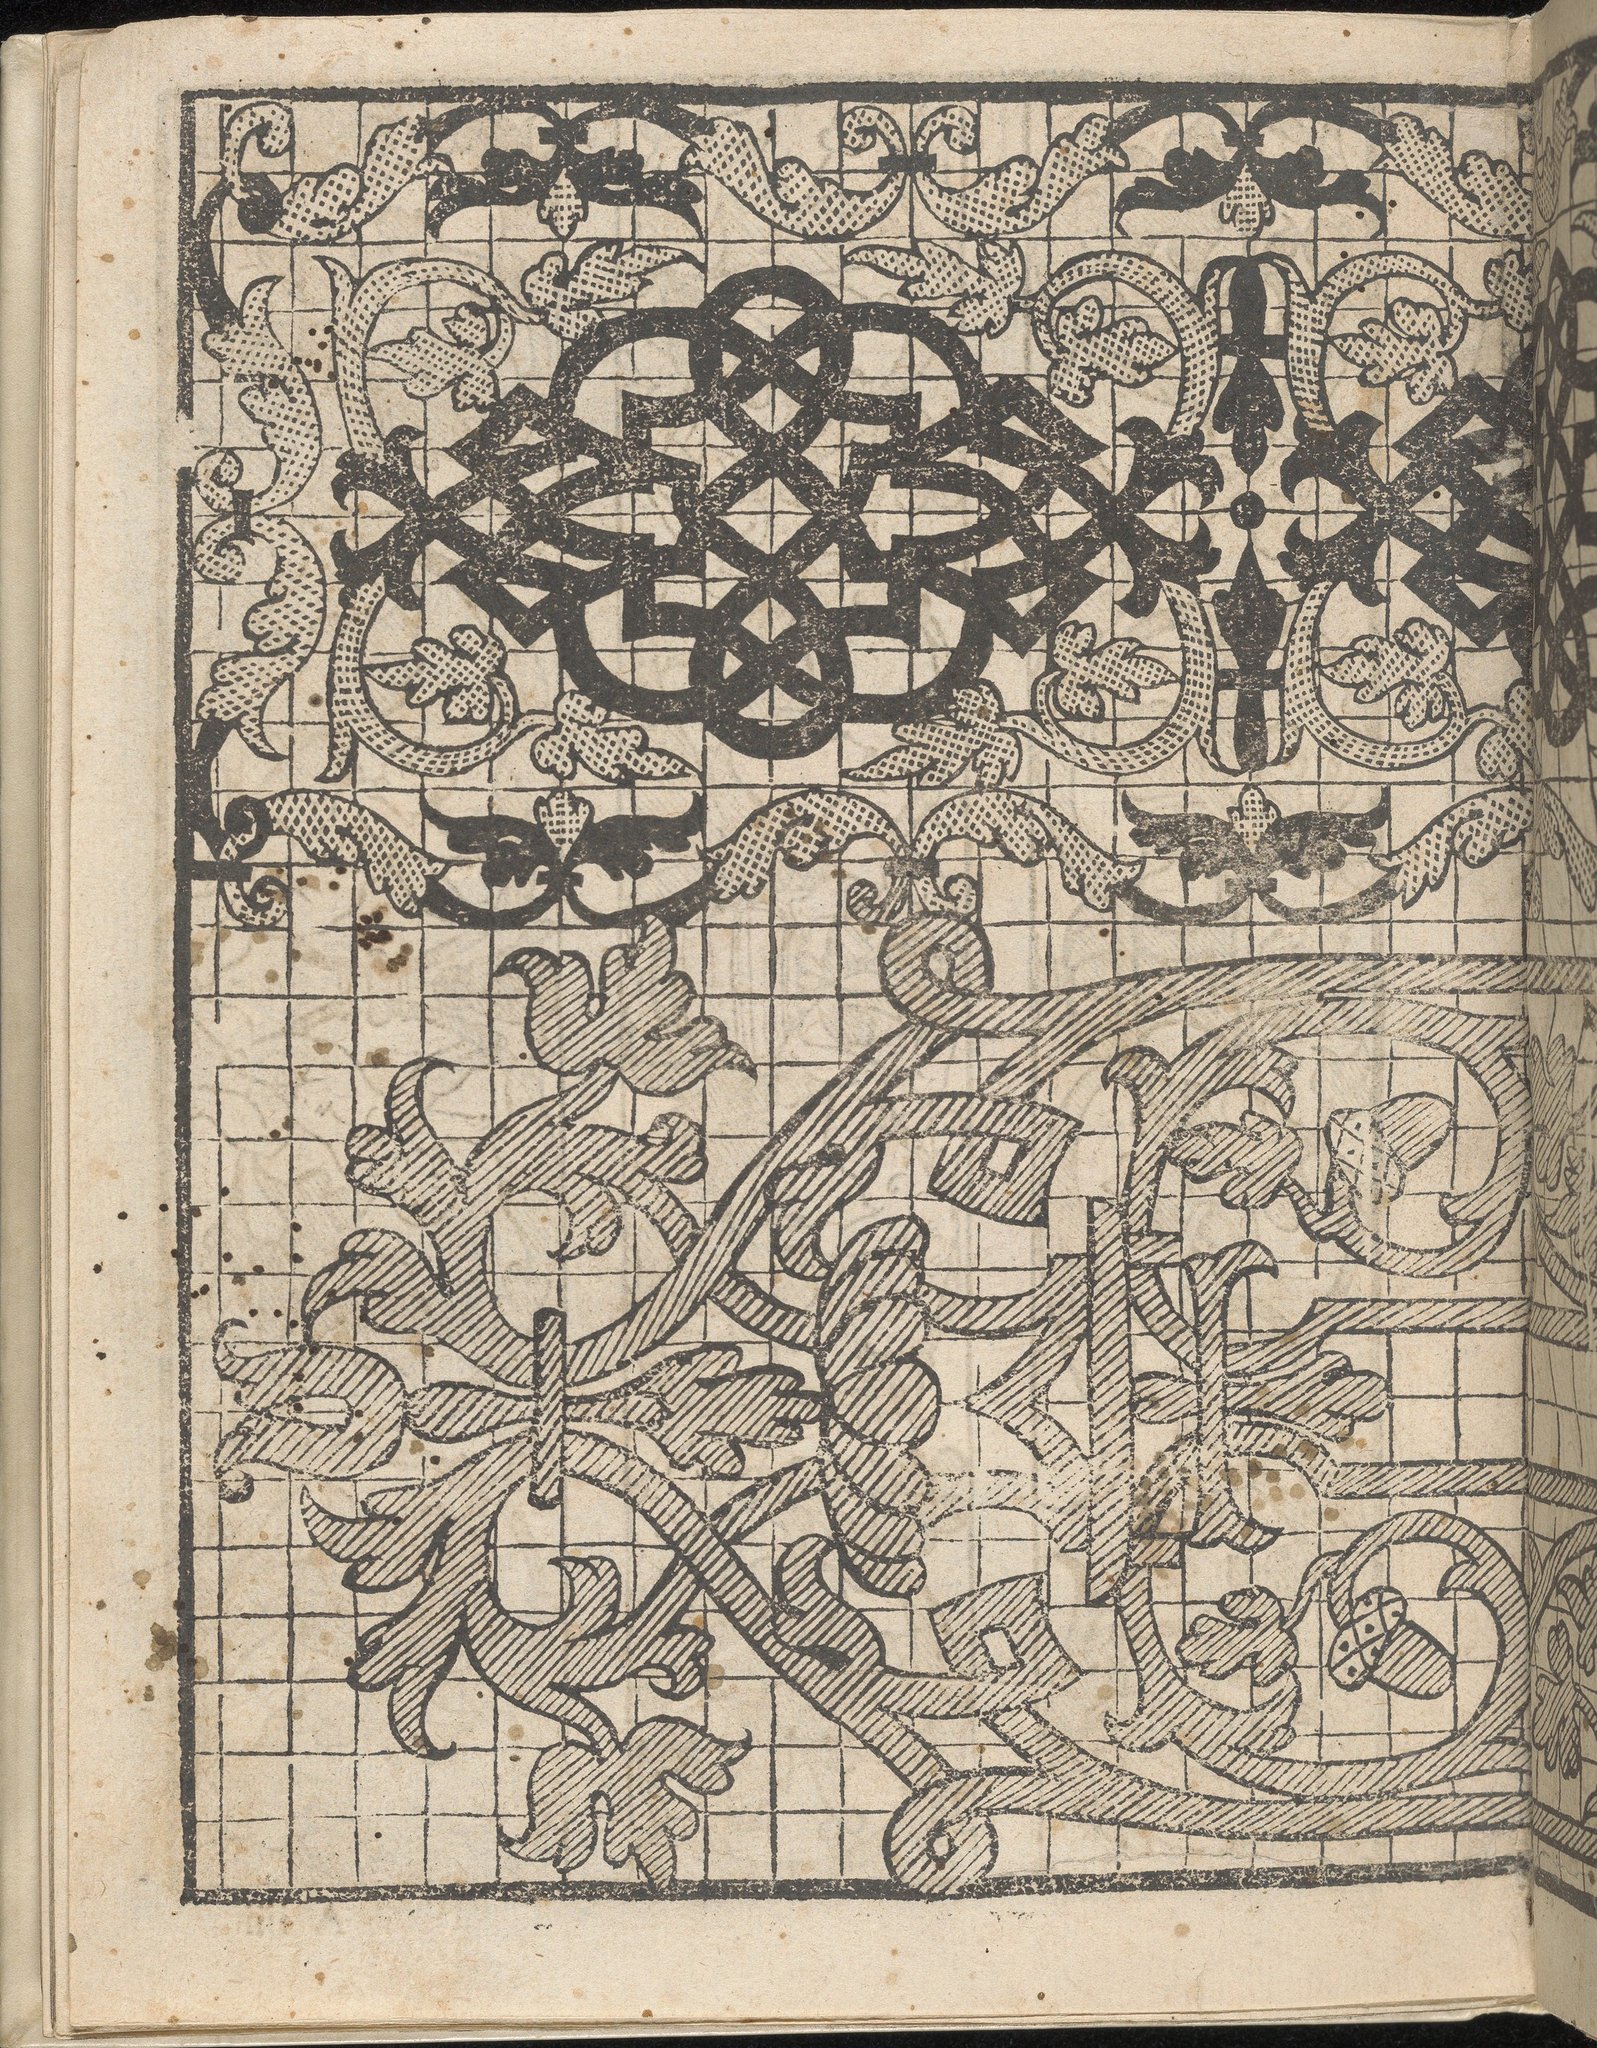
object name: book print ornament architecture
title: Lucidario di Recami, page 4 (verso)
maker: iseppo foresto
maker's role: designer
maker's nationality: italian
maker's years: 1520-1580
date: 1564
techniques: woodcut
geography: italy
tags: ornament